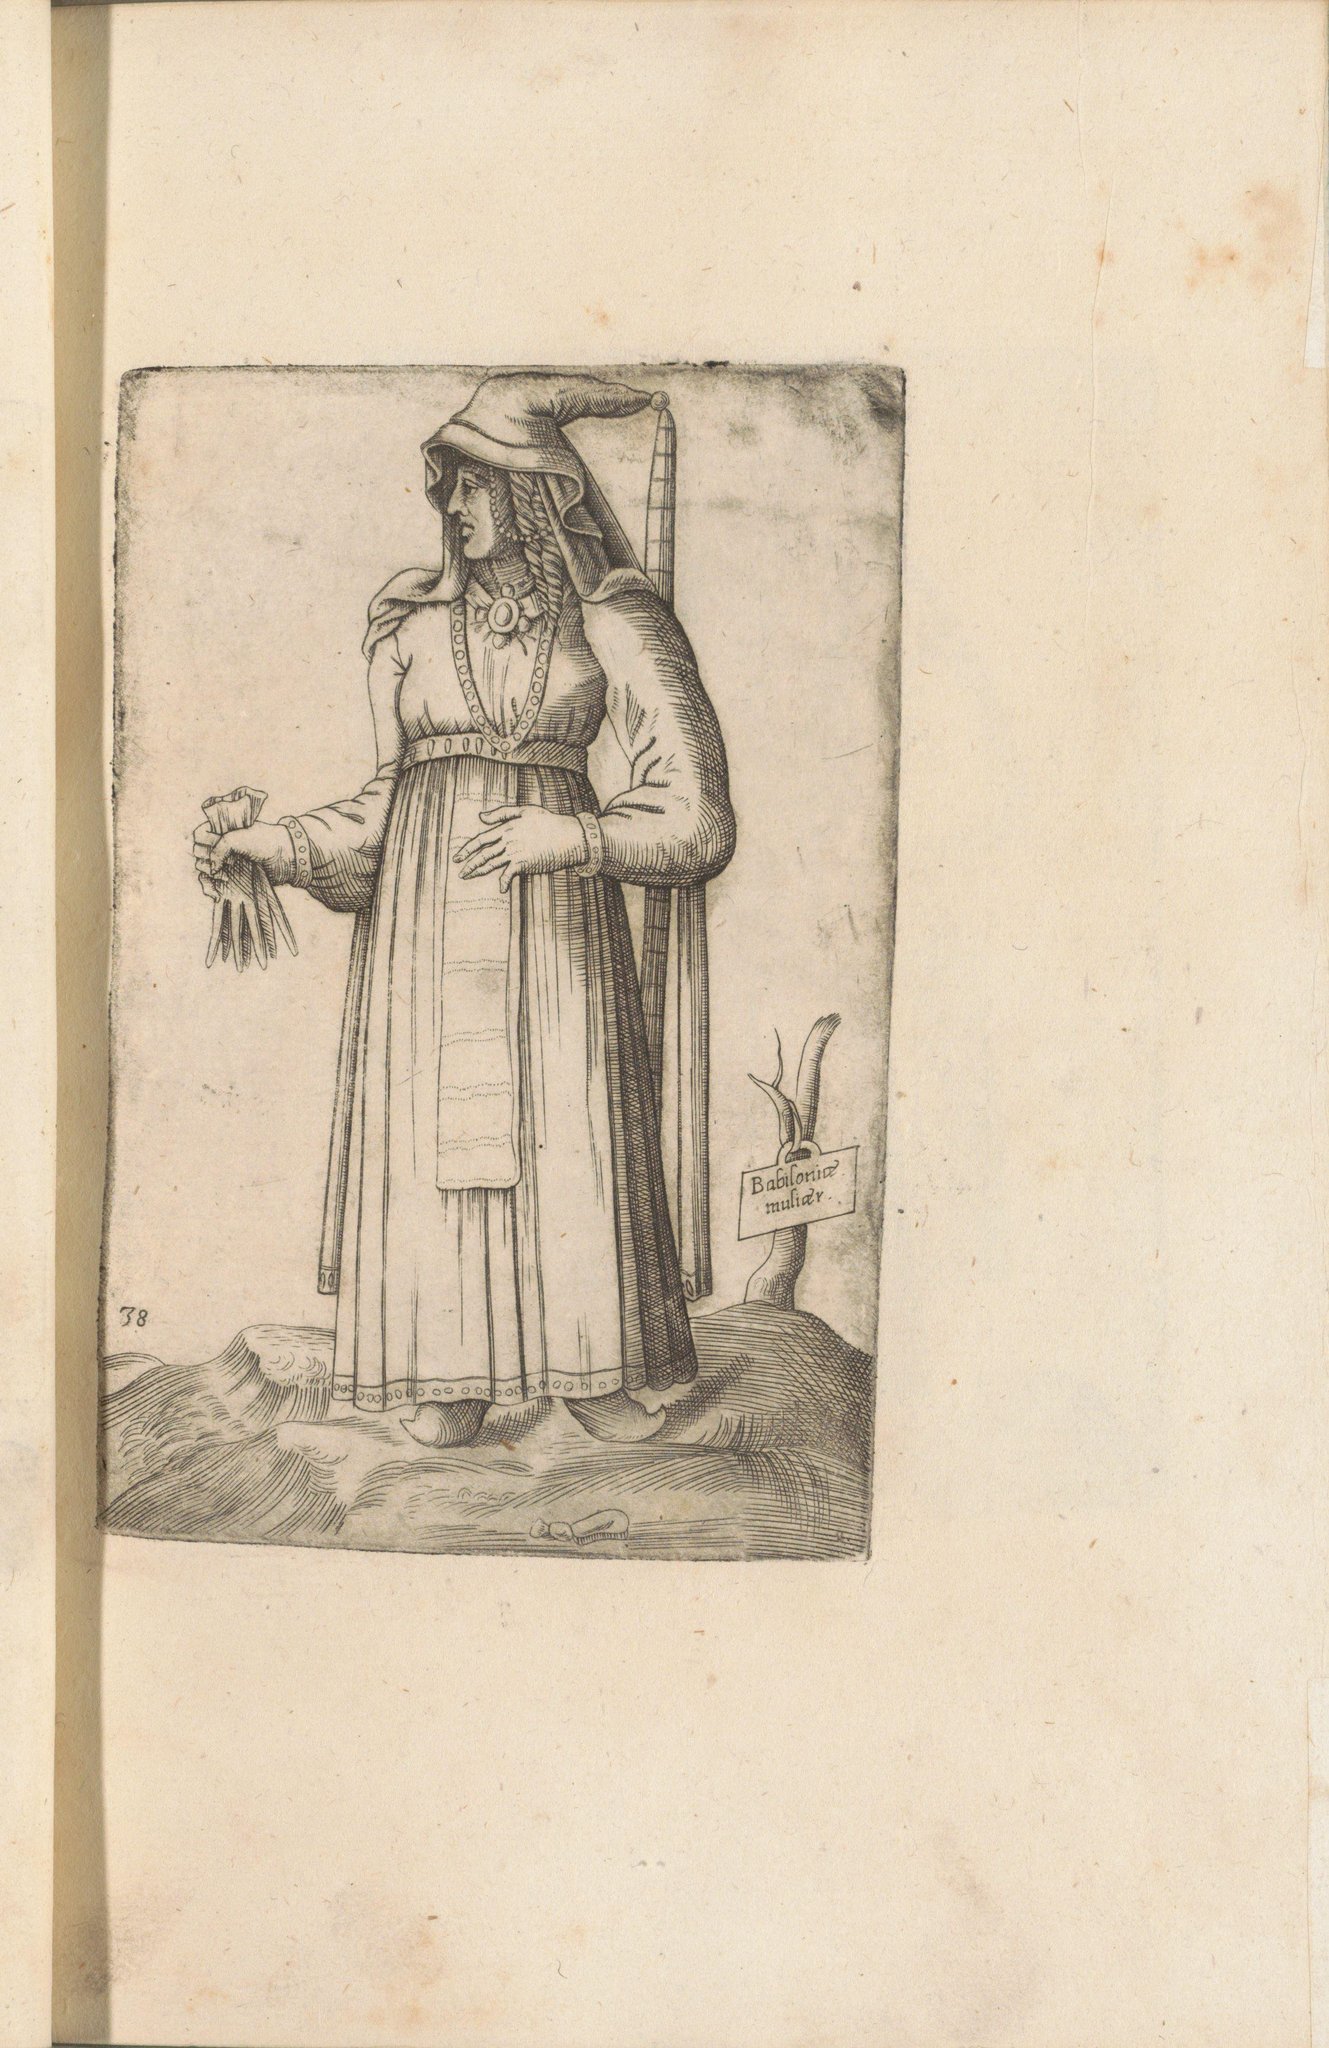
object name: costume print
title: Babiloniae mulier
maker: ferando bertelli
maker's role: print maker, publisher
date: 1569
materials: paper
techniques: engraving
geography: venice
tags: fashion plates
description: Babylonische vrouw, naar links, handschoenen in de hand, met puntvormig hoofddeksel waaraan een doek hangt. Onderdeel van het kostuumboek getiteld 'Omnium fere gentium nostrae aetatis habitus, nunquam ante hac aediti', Venetië 1569. Heruitgave uit 1569 van de eerste editie uit 1563.